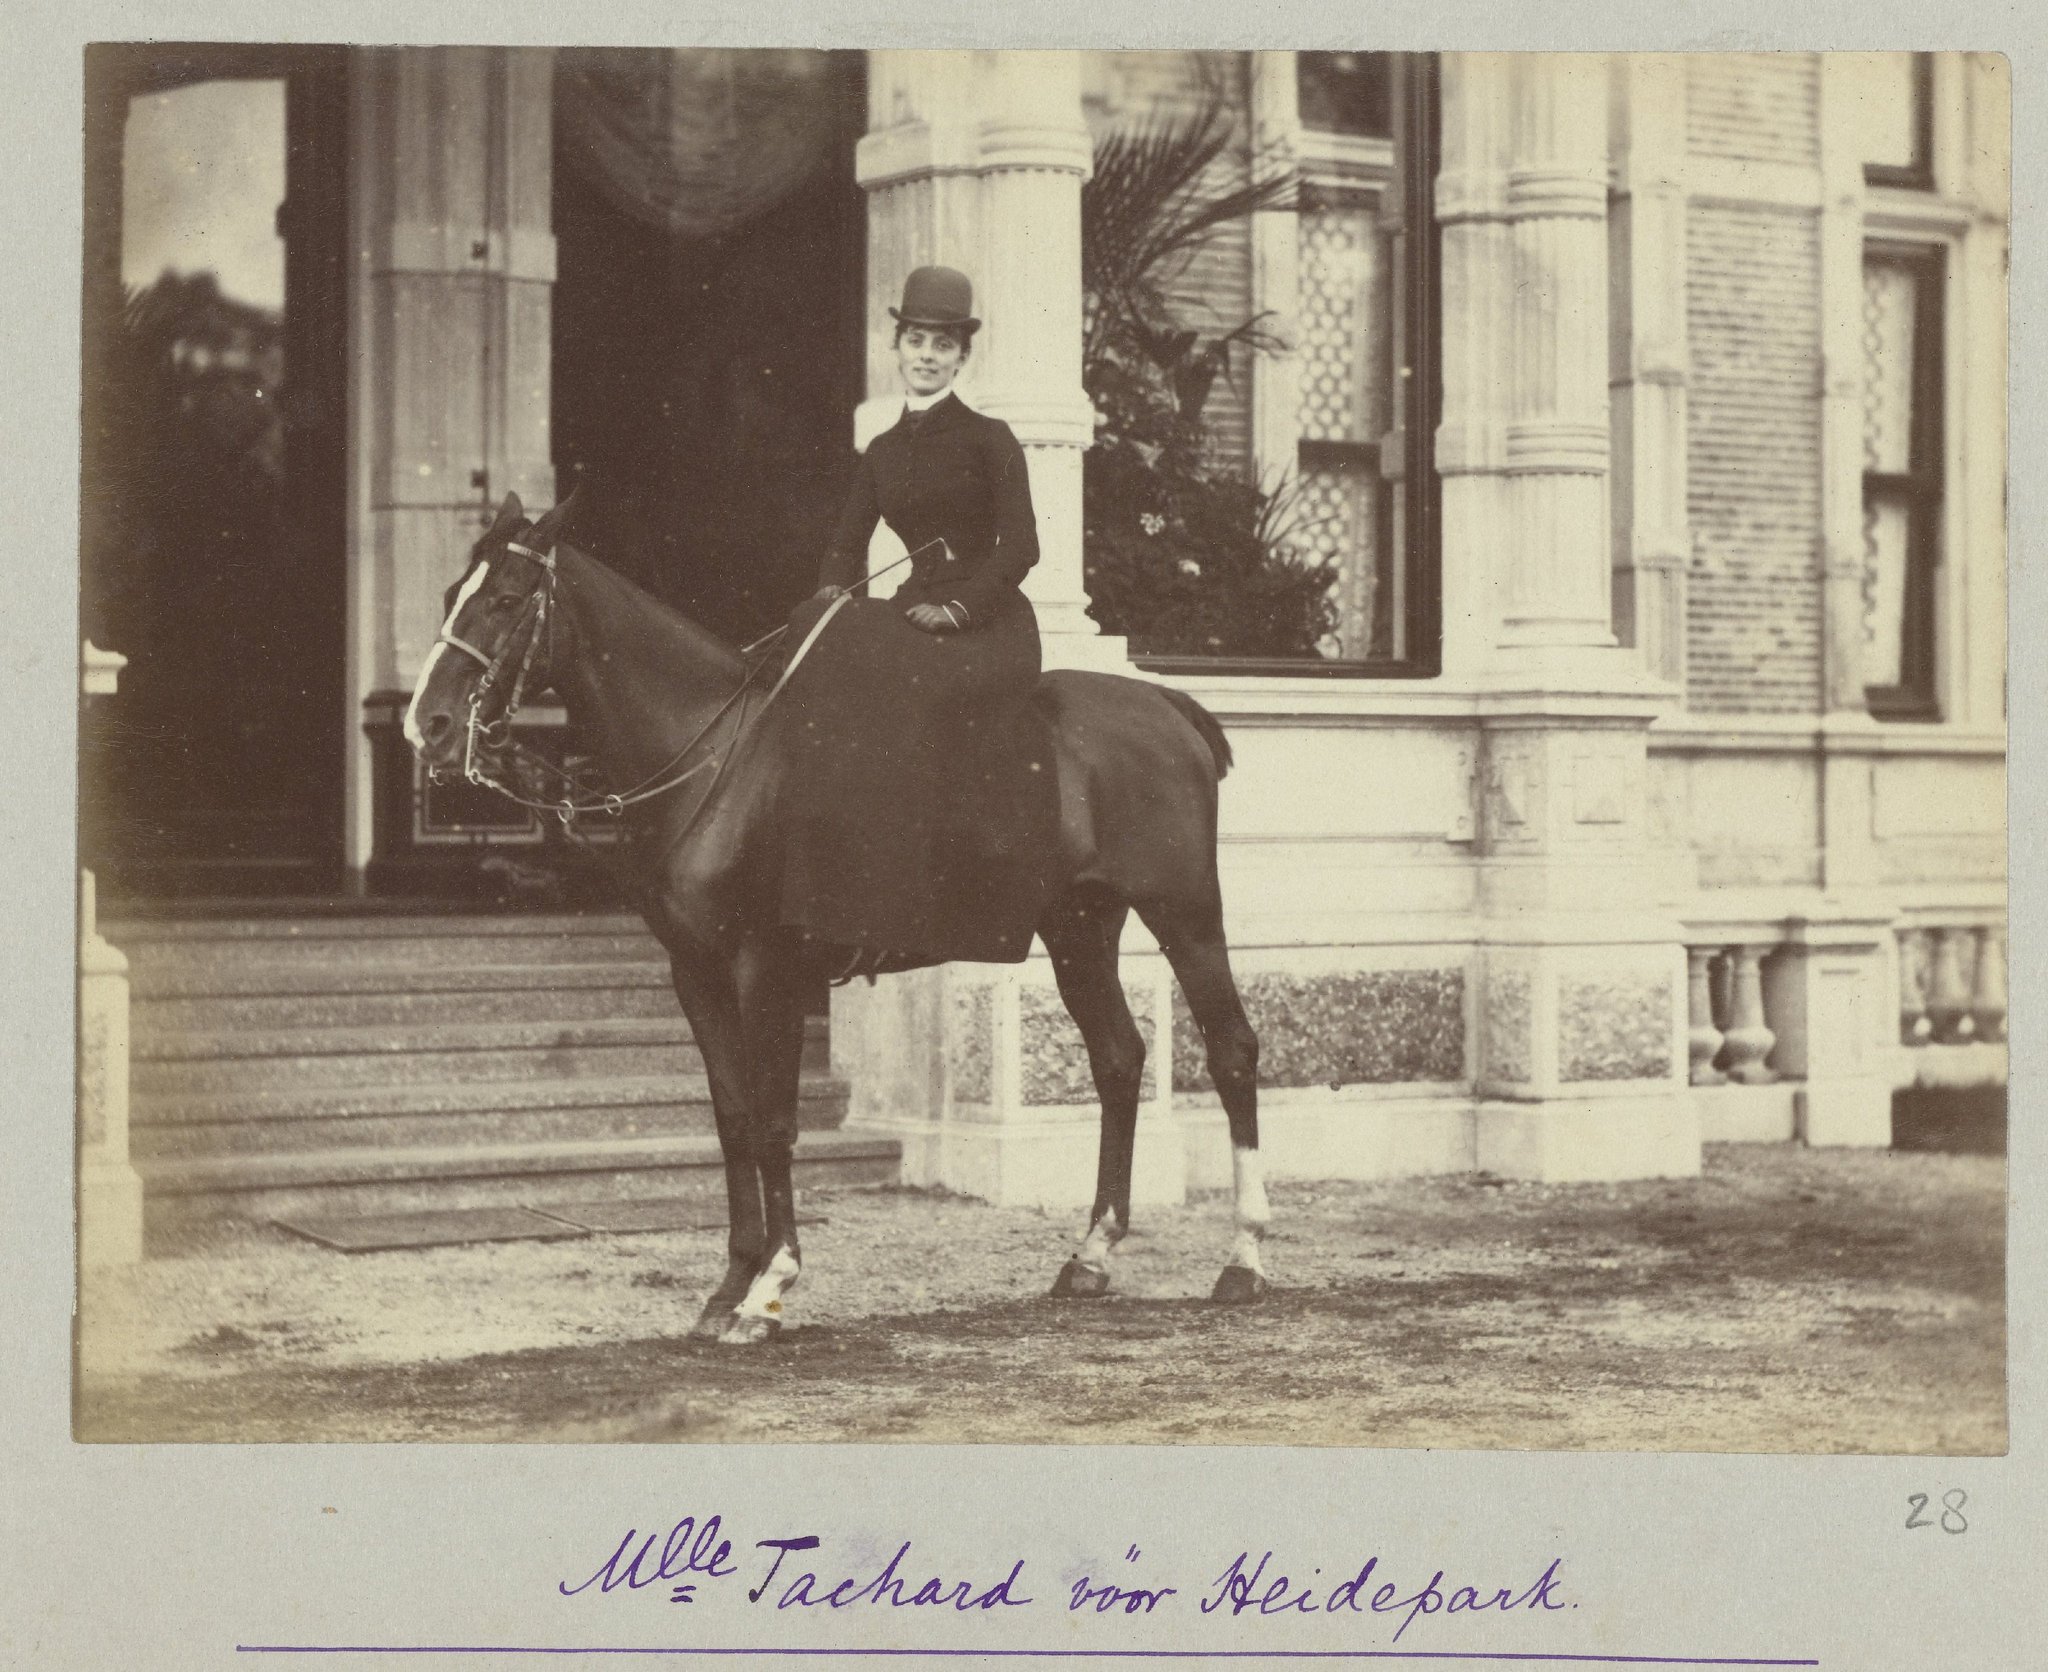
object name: photograph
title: Mejuffrouw Tachard te paard voor huis Hydepark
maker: henry pauw van wieldrecht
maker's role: fotograaf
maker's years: 1863-1912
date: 1888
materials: paper, photographic support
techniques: albumen print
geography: netherlands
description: Met onderschrift: Mme Tachard voor Heidepark.